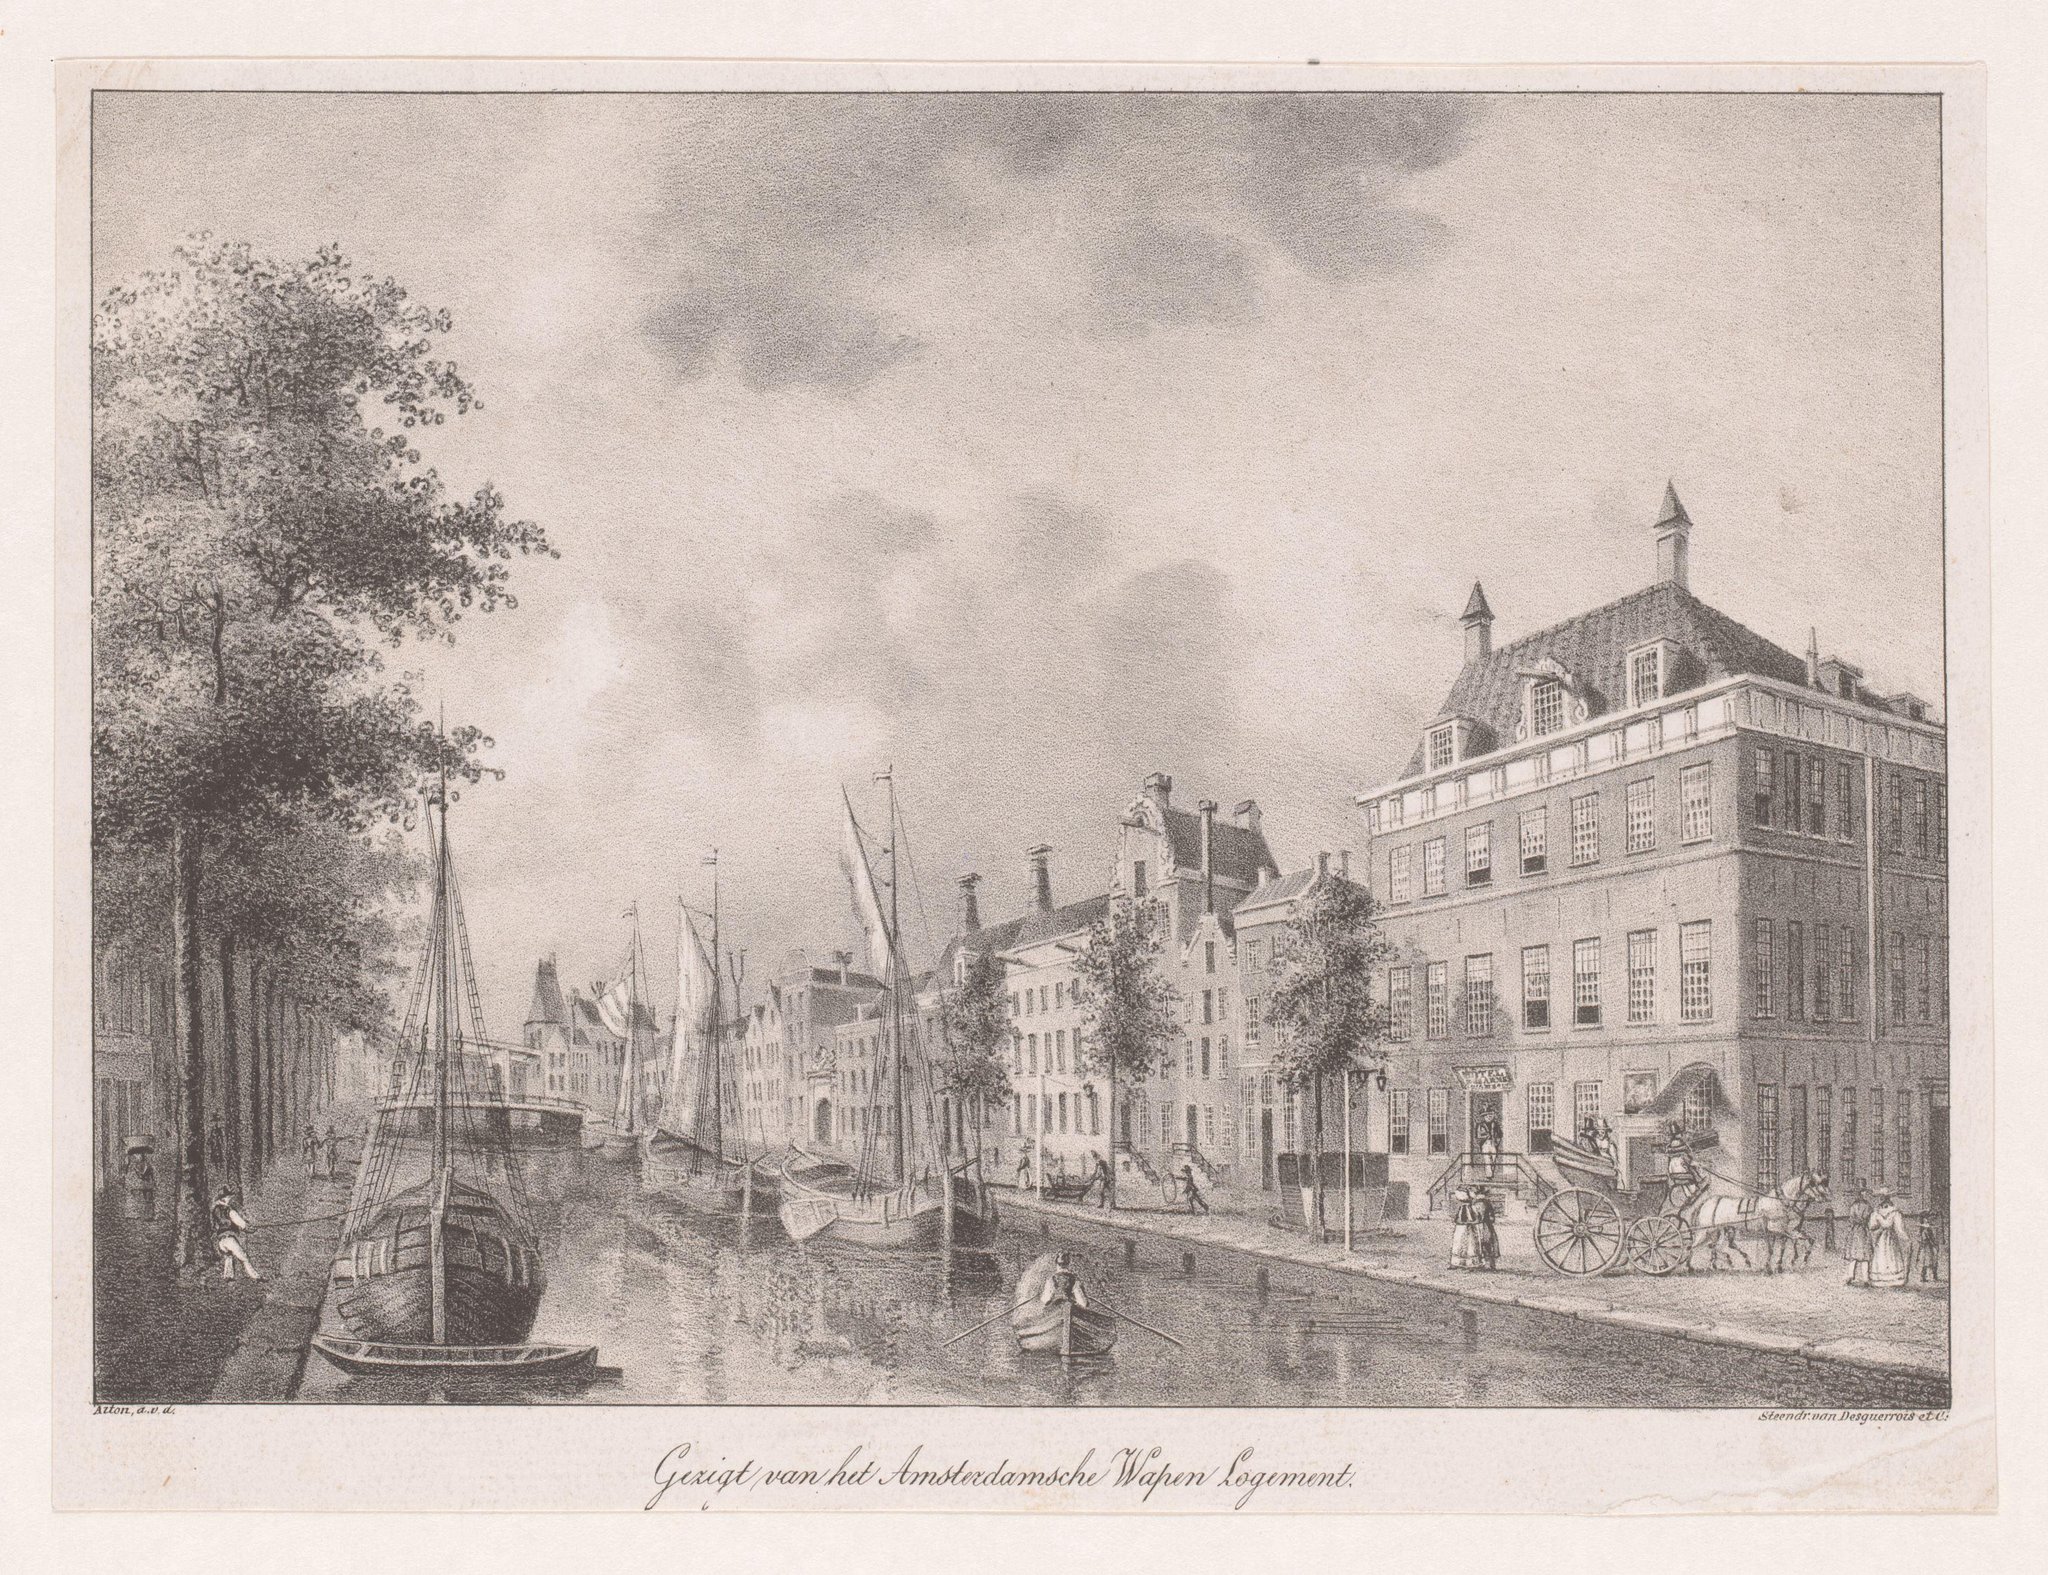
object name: print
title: Het Wapen van Amsterdam aan de Kloveniersburgwal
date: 1827-1927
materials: paper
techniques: lithograph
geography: amsterdam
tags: sailing-ship, sailing-boat, canals, waters (in city), hotel, hostelry, inn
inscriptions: collector's mark: Lugt 2760, collector's mark: Lugt 2228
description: Het gebouw staat rechts van het water op de hoek met Rusland. Op het water liggen zeilboten en een kleine roeiboot.